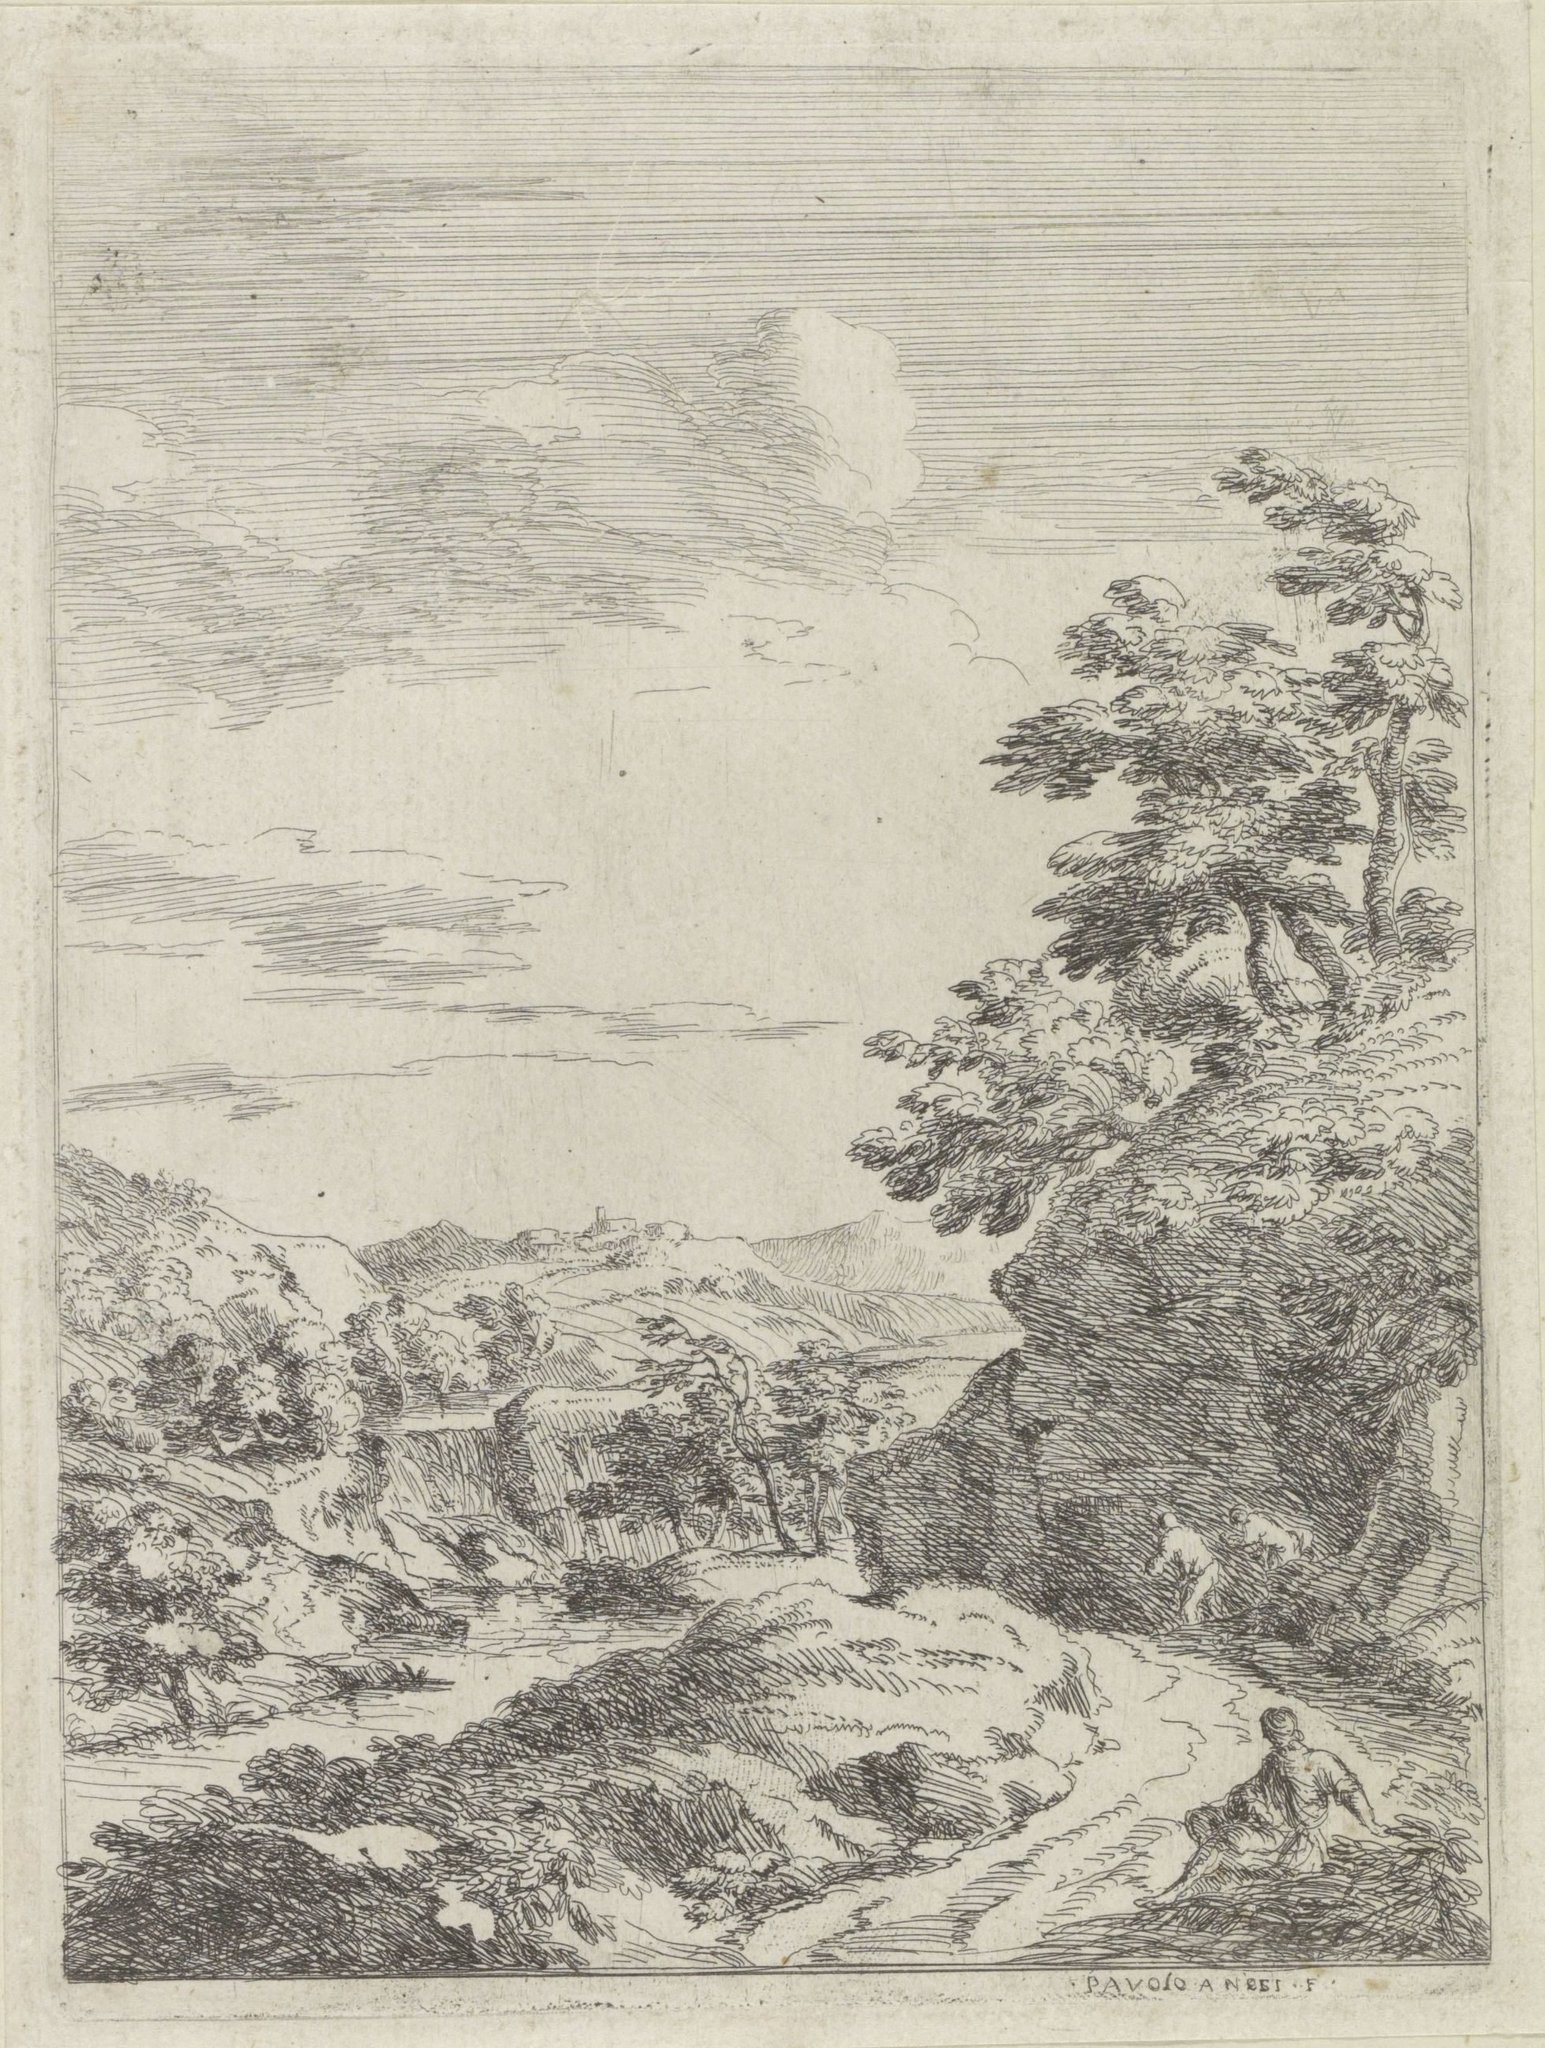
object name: print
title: Heuvellandschap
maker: paolo anesi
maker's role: print maker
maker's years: 1700-1761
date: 1710-1761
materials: paper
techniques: etching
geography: italy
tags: low hill country, landscapes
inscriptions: collector's mark: Lugt 240